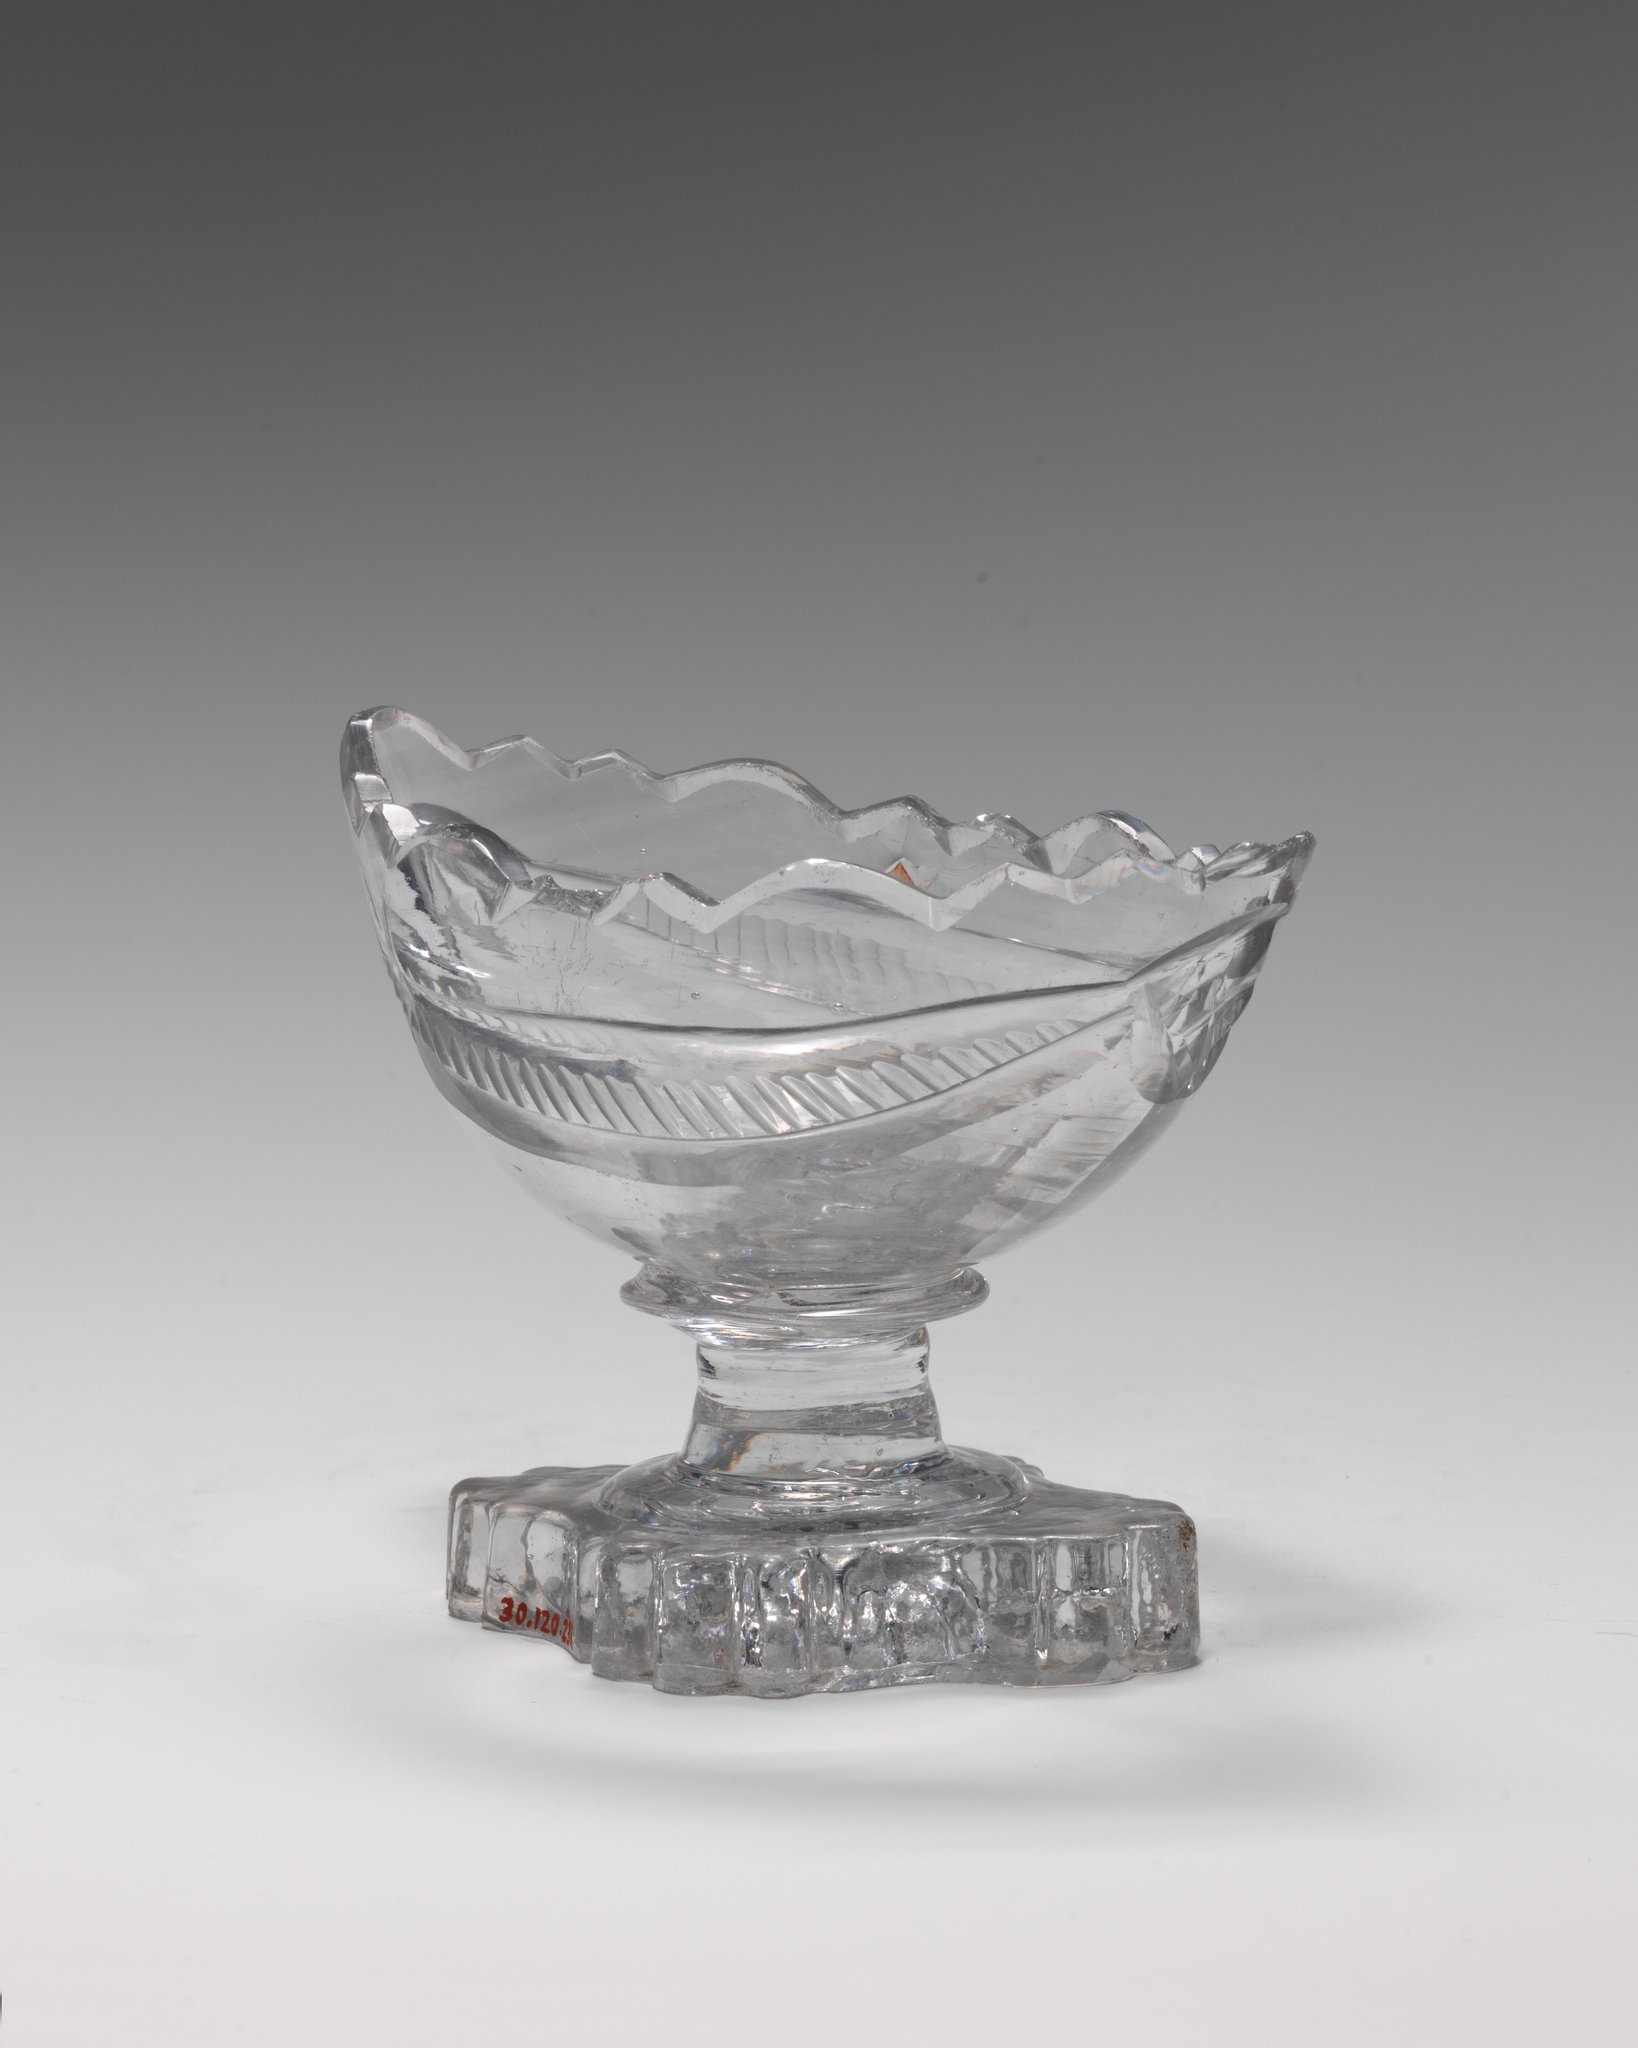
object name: salt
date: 1767-1800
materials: glass